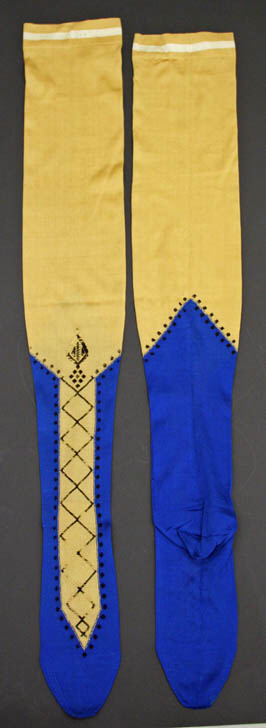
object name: stocking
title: Stockings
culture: french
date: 1865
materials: silk